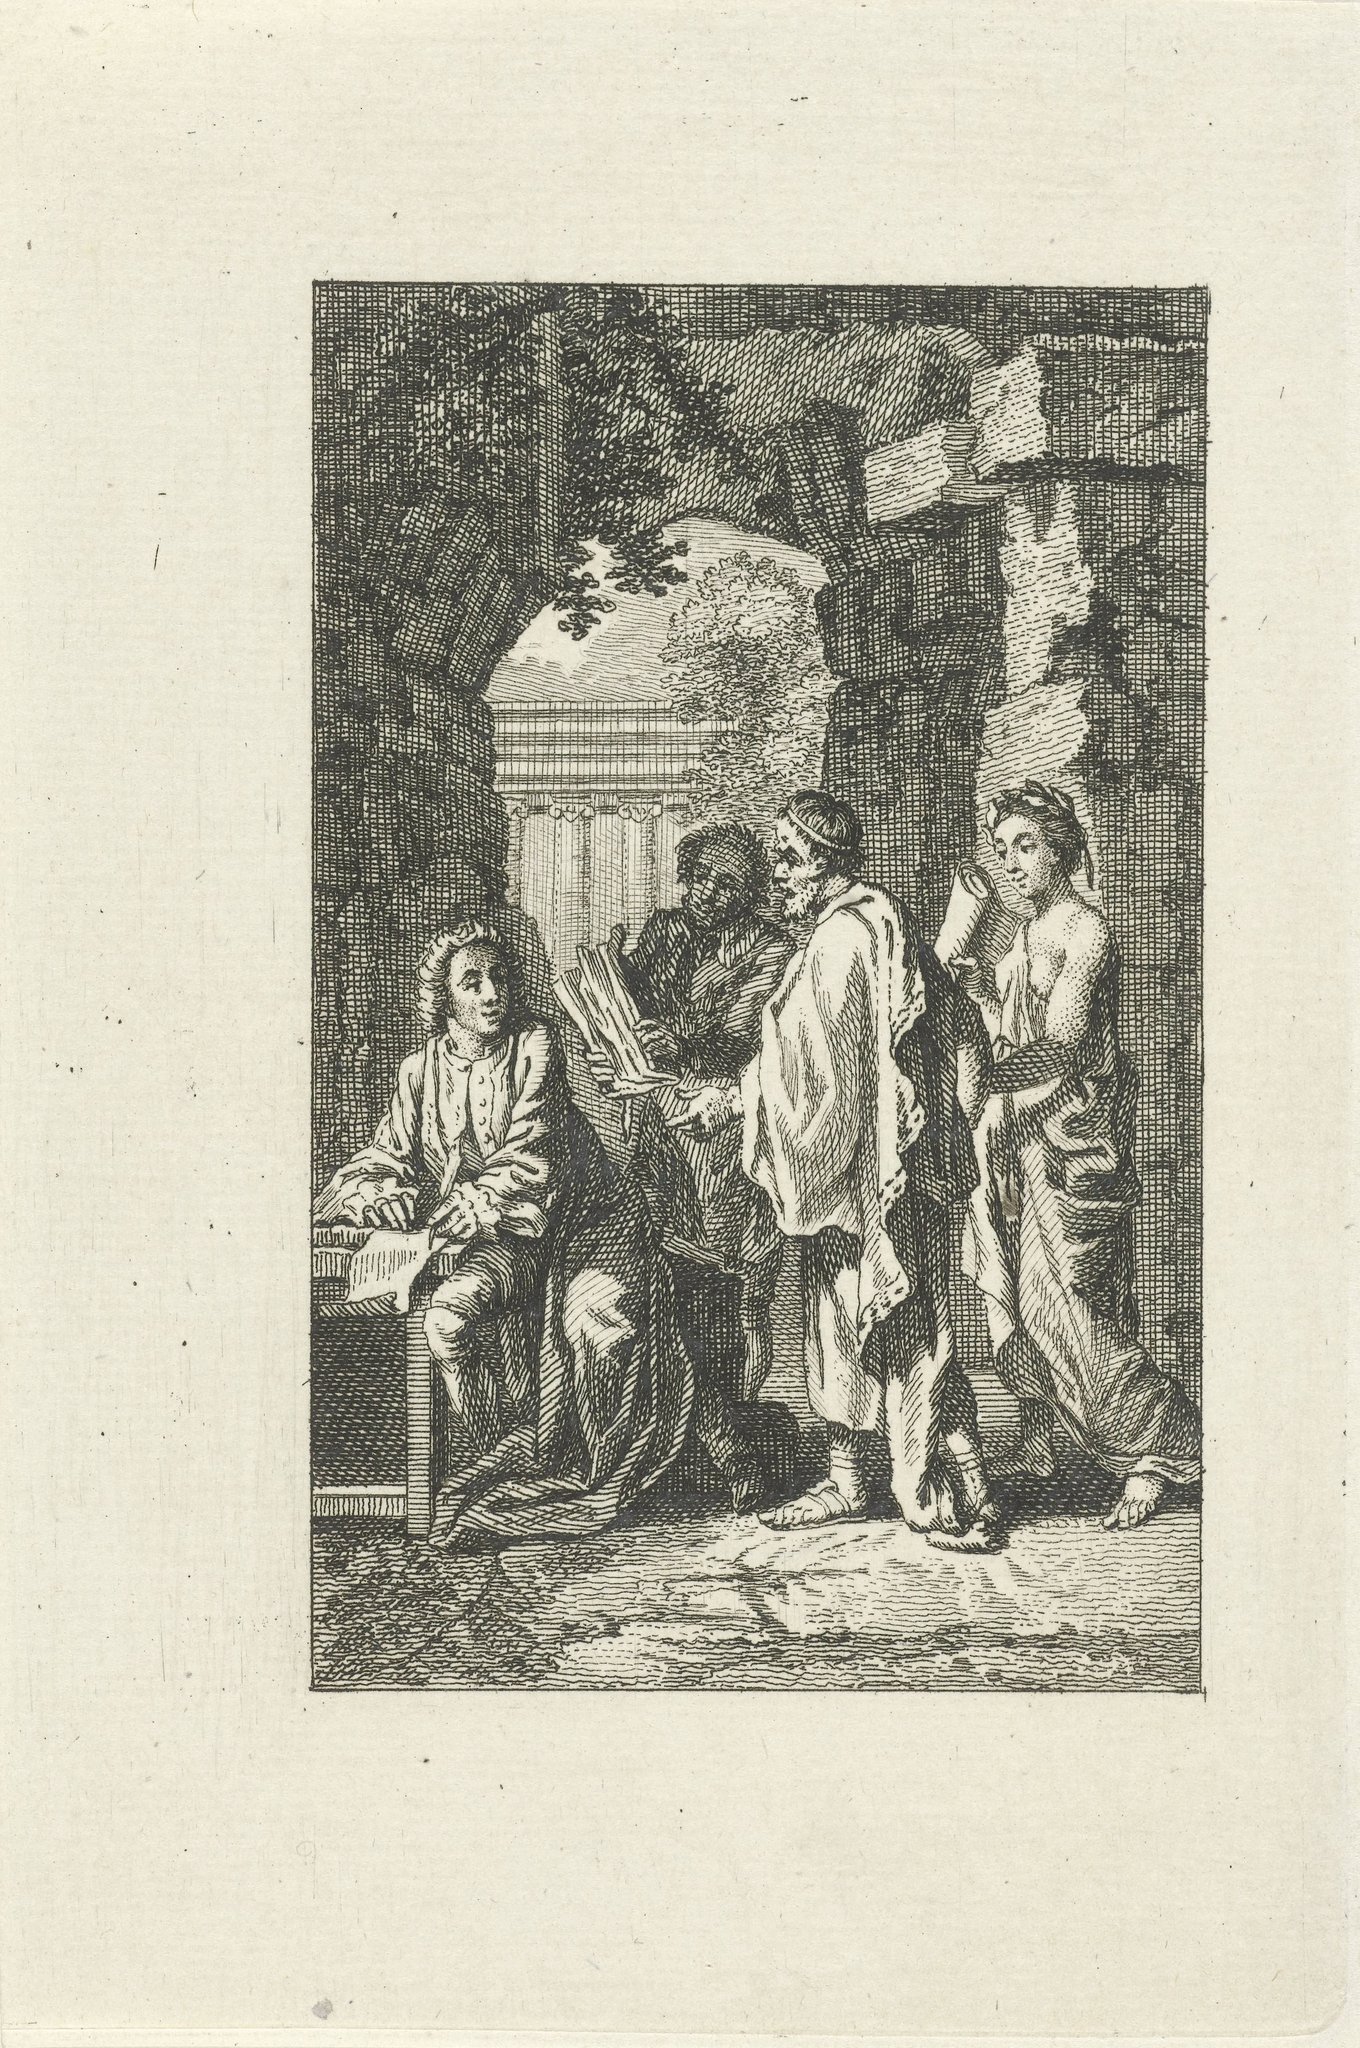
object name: print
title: Drie figuren bezoeken een schrijver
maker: Anonymous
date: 1702-1817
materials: paper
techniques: etching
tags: author, poet writing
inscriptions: collector's mark: Lugt 2228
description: Een schrijver zit met een ganzenveer aan een tafel te schrijven. Hij kijkt op naar een man en vrouw in toga die hem komen bezoeken. De vrouw is gelauwerd en houdt een rol papier in haar handen. Achter de schrijver staat onder een boog een derde man met een boek in zijn handen.